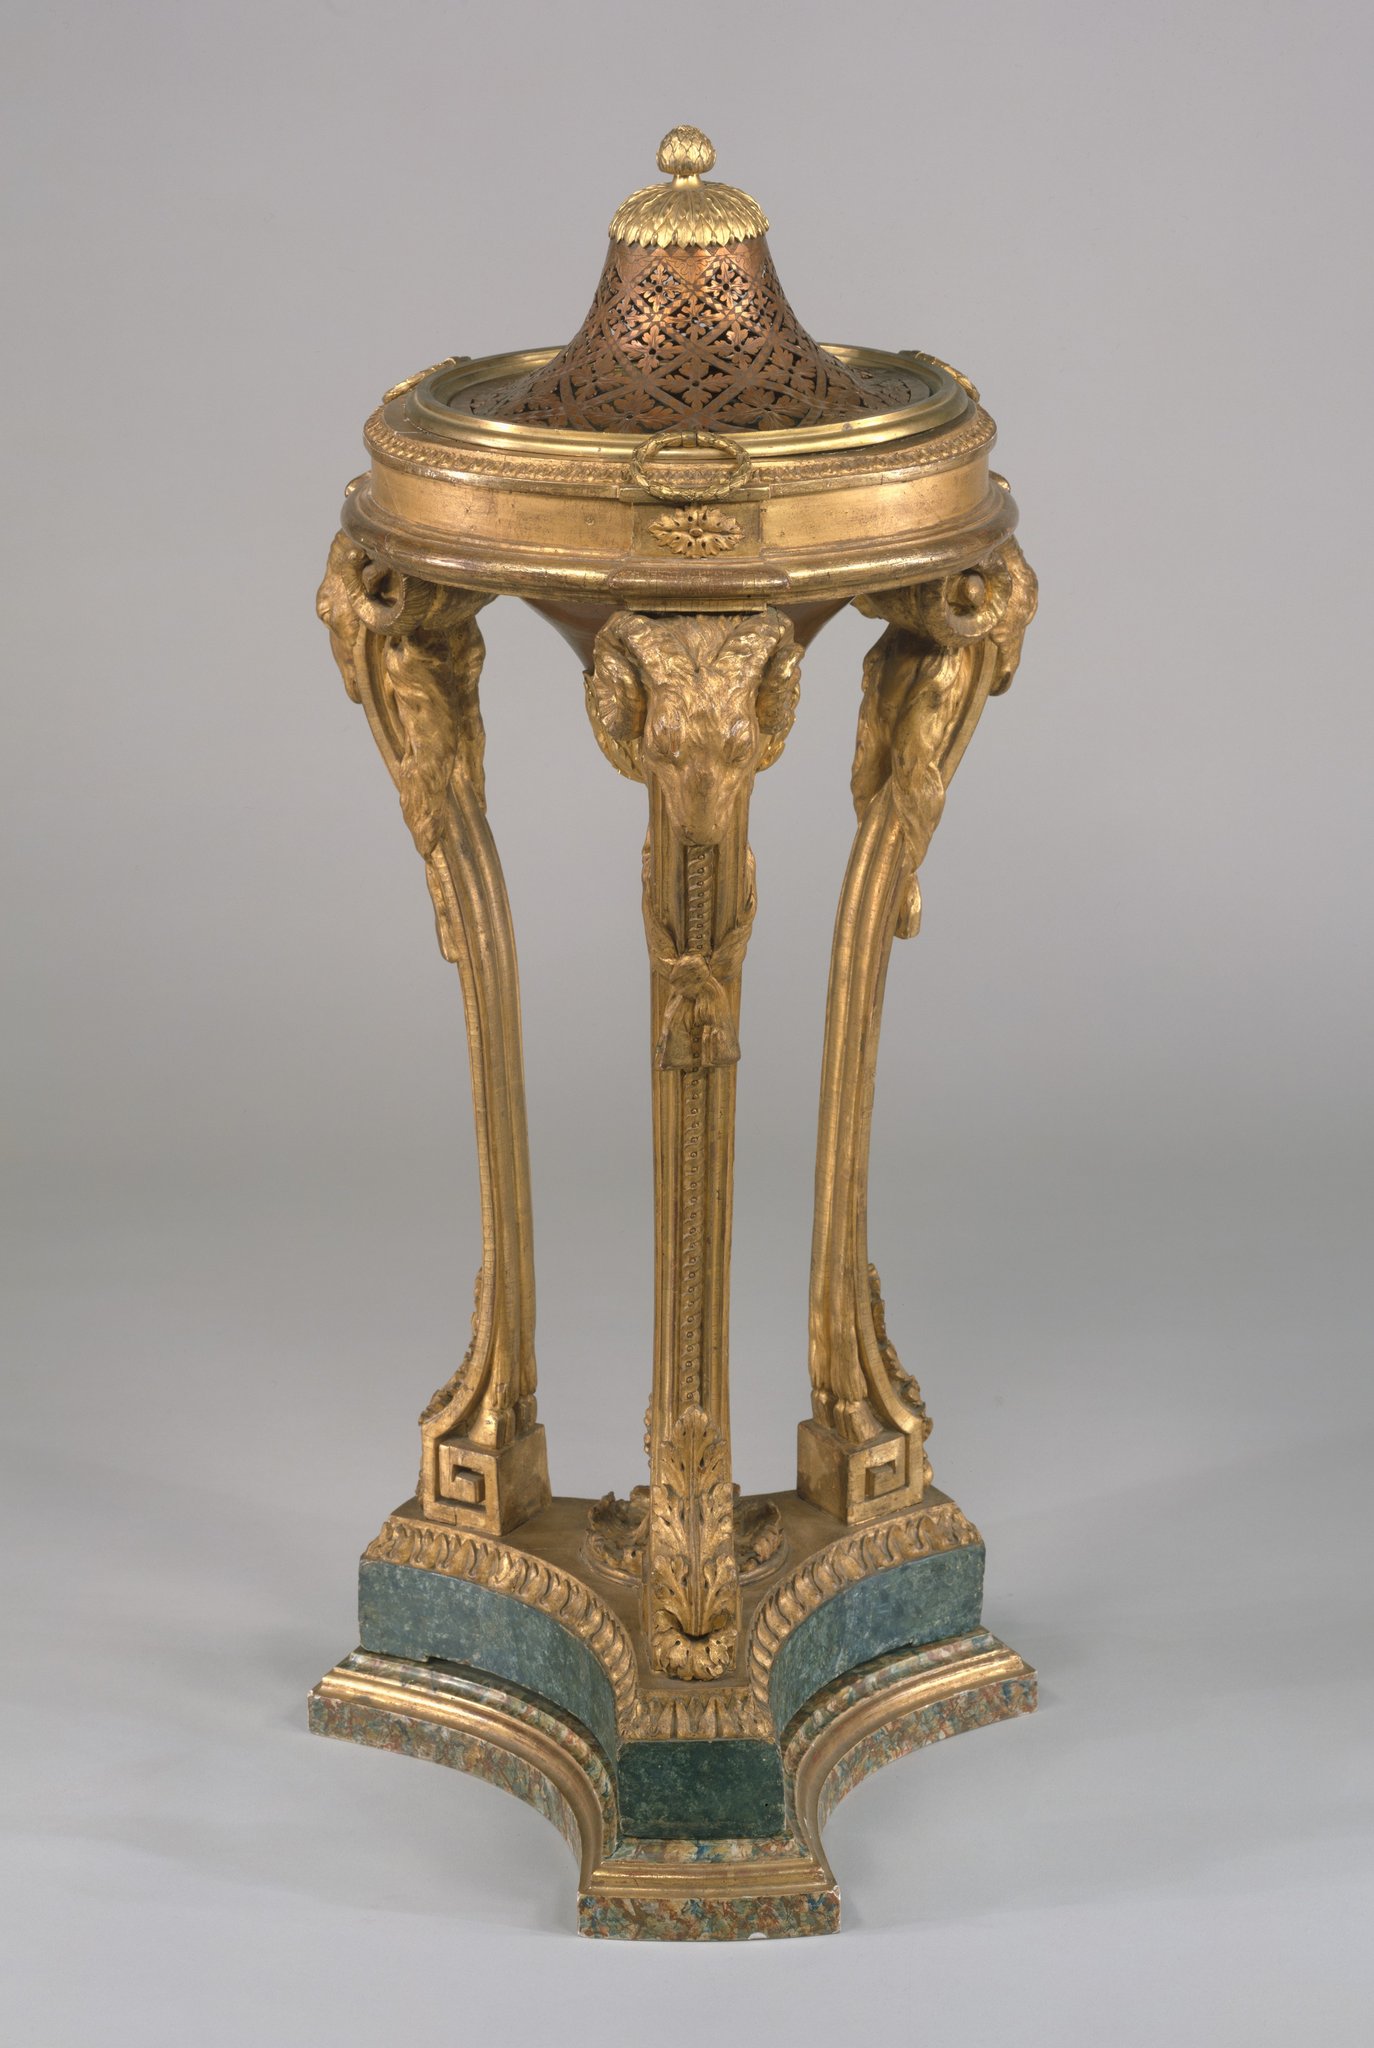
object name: incense burner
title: Incense burner (brûle-parfum)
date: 1775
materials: wood, copper, gilt bronze, tin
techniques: gilding